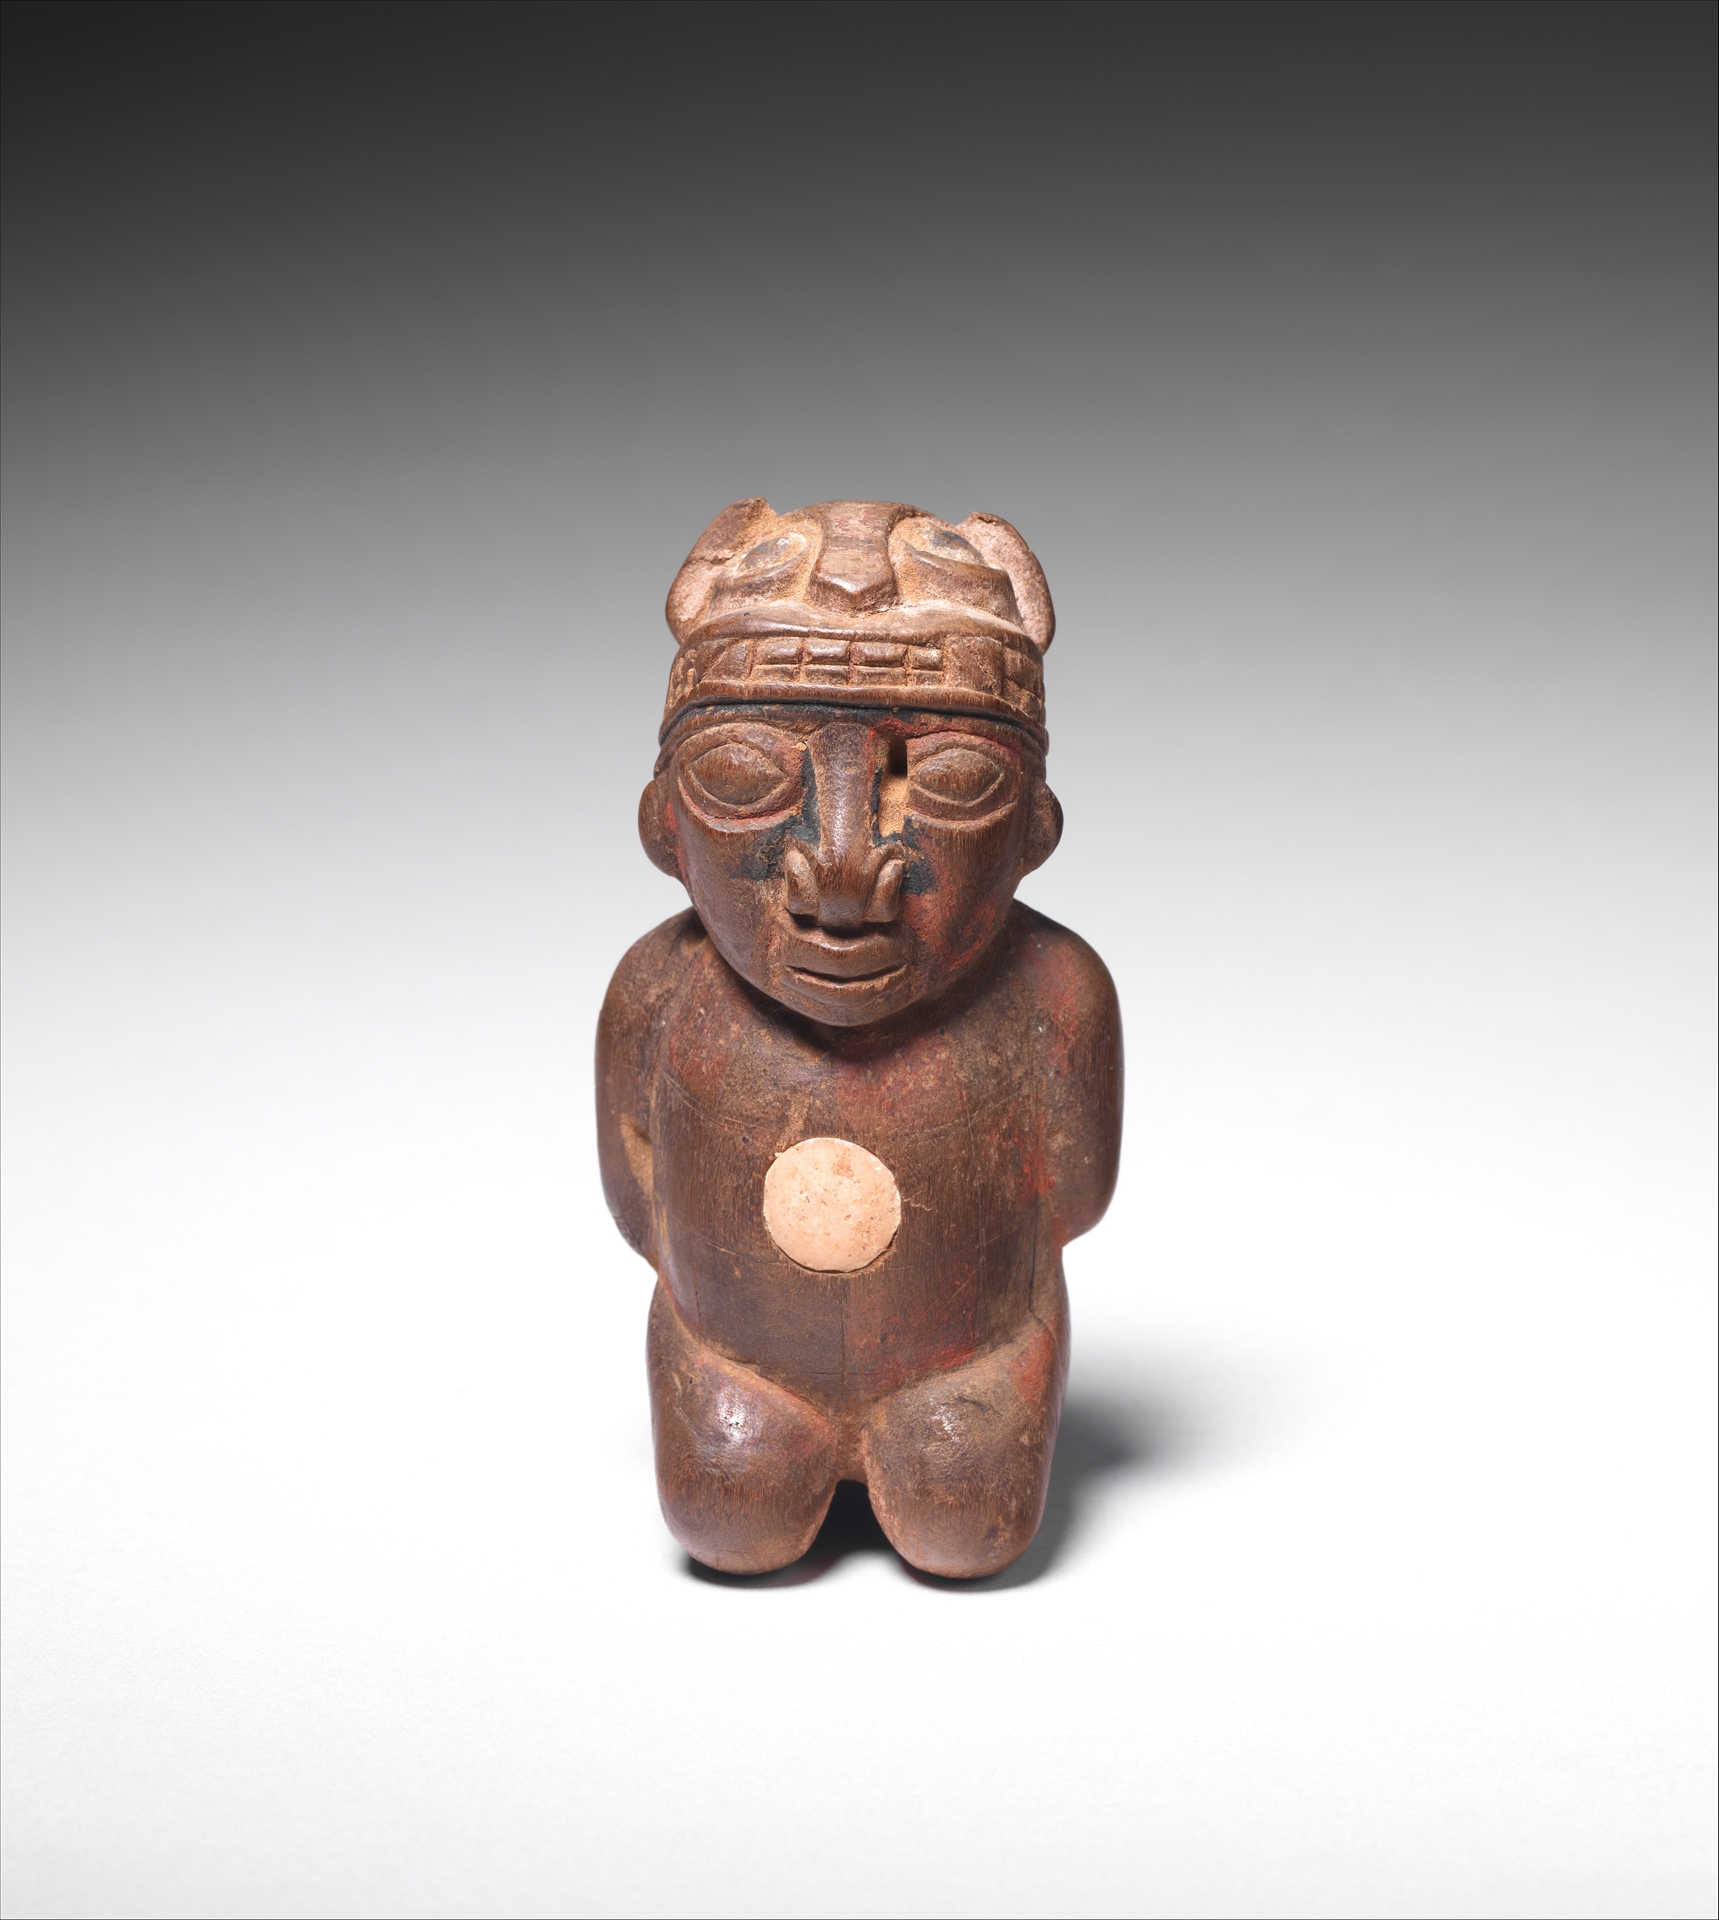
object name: lime container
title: Lime container in the shape of a captive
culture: wari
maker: wari artist(s)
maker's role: artist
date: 650-1000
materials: bone, fiber, paint, wood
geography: peru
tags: prisoners